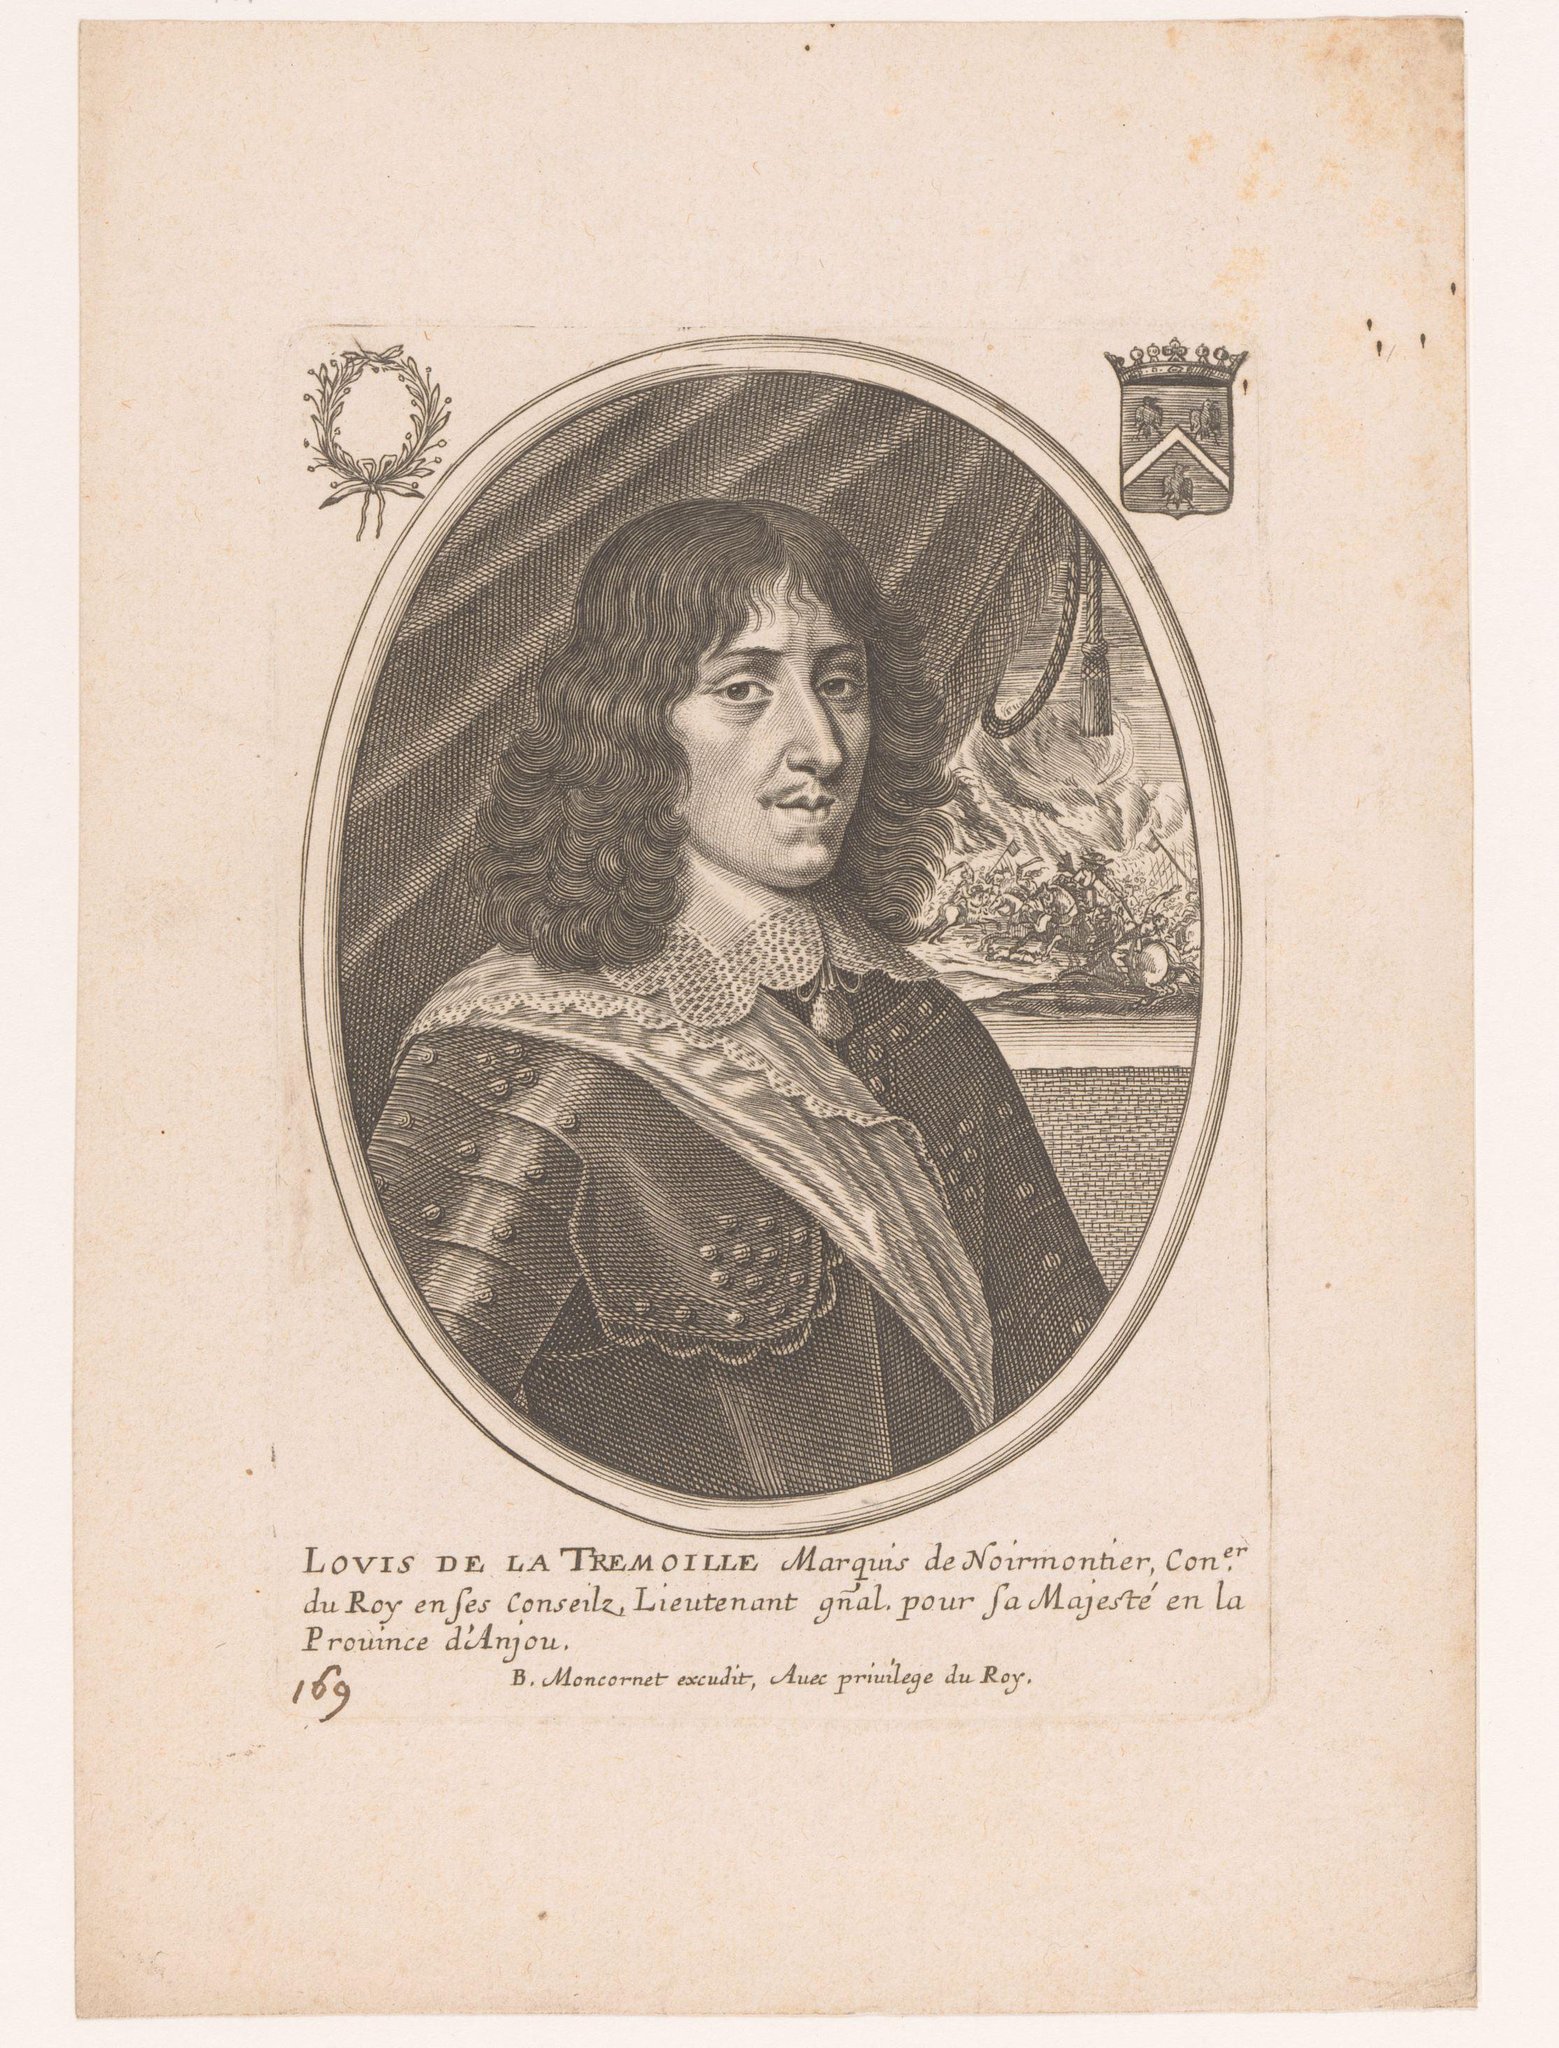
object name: print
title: Portret van Louis II de La Trémoille-Noirmoutier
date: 1642-1668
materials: paper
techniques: engraving, etching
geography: paris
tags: historical persons, armorial bearing, heraldry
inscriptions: collector's mark: Lugt 2228